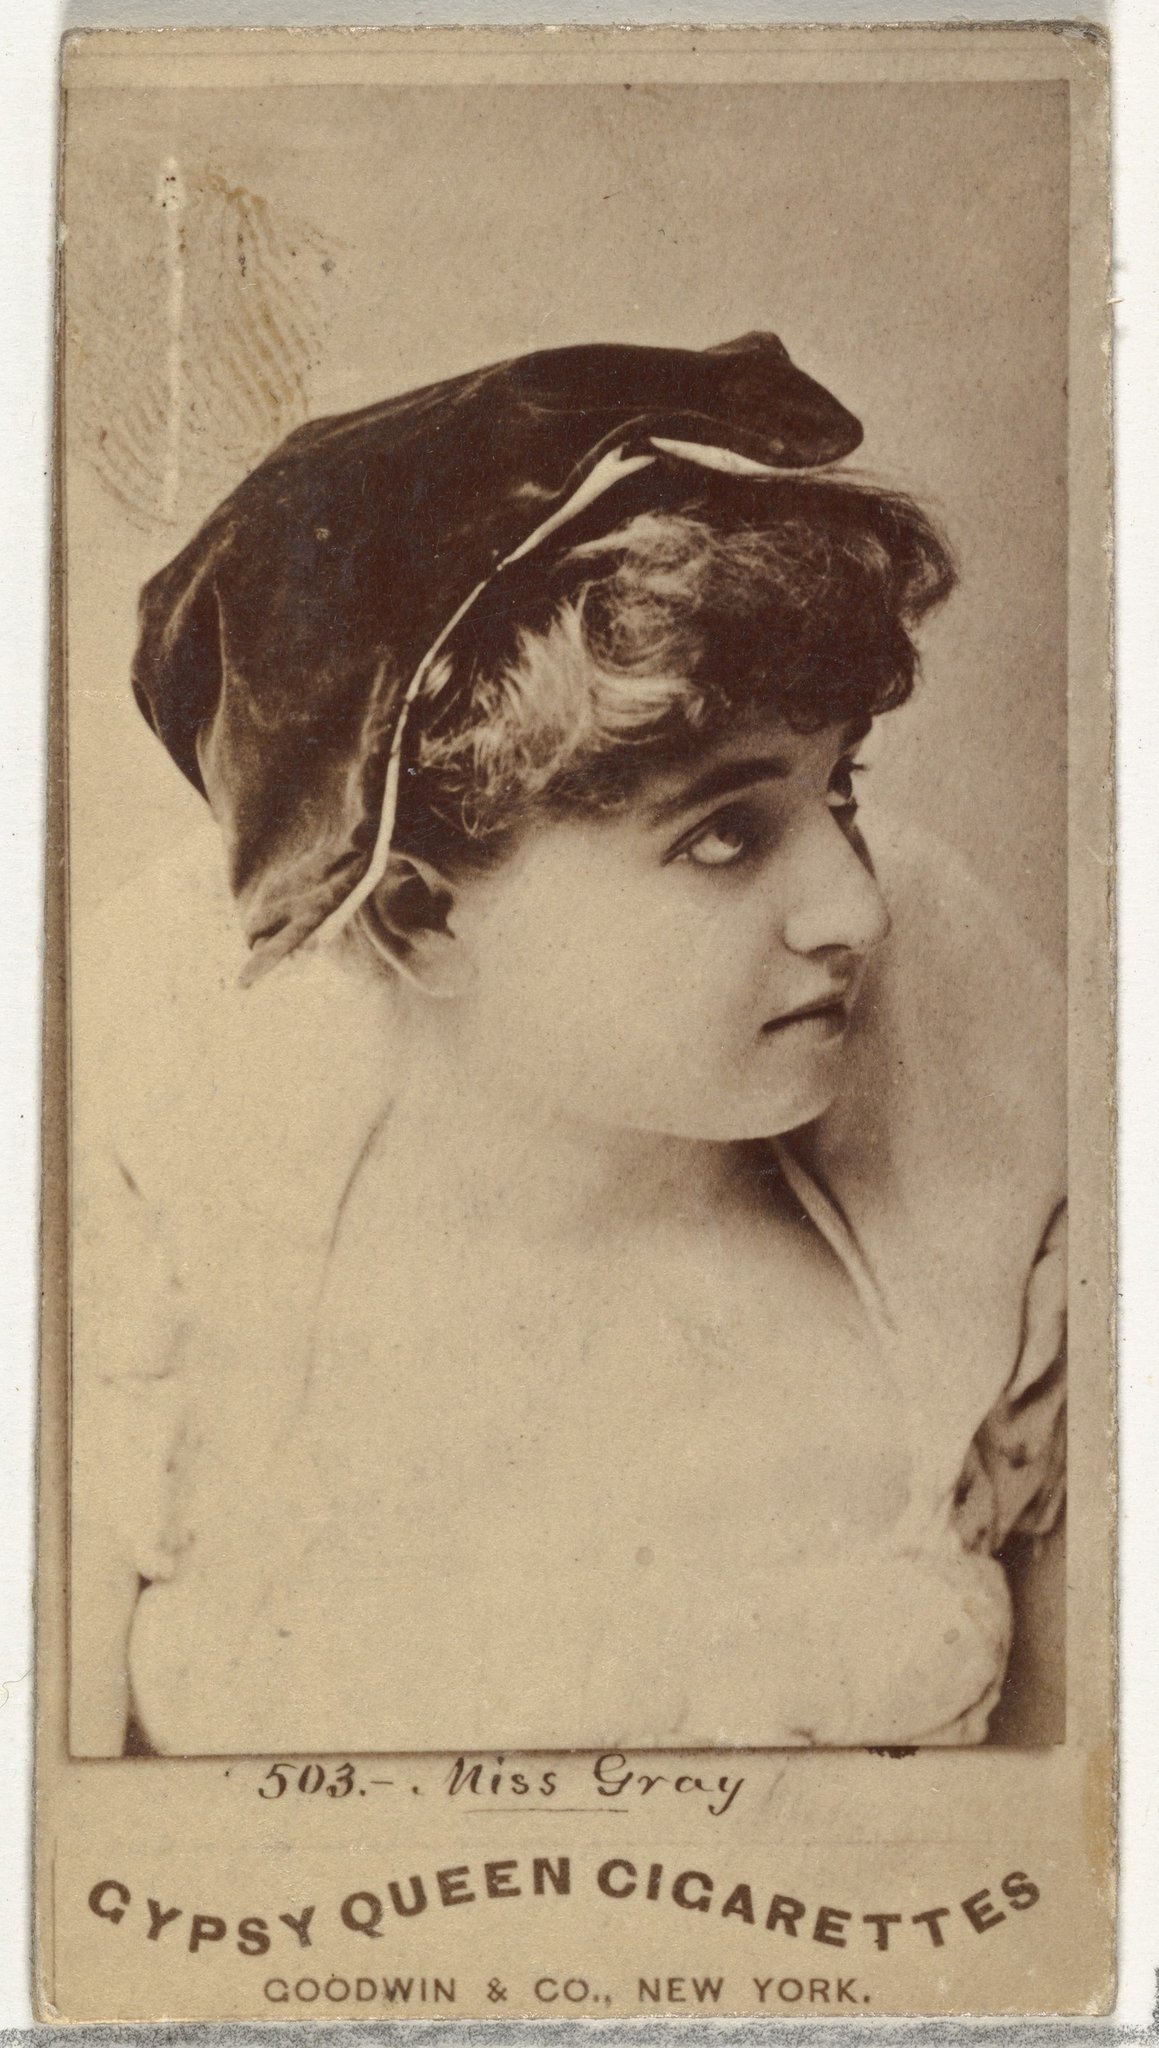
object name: photograph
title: Miss Gray, from the Actors and Actresses series (N171) for Gypsy Queen Cigarettes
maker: goodwin & company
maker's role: publisher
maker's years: 1850-1950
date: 1886-1890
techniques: albumen silver print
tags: portraits,women,actresses